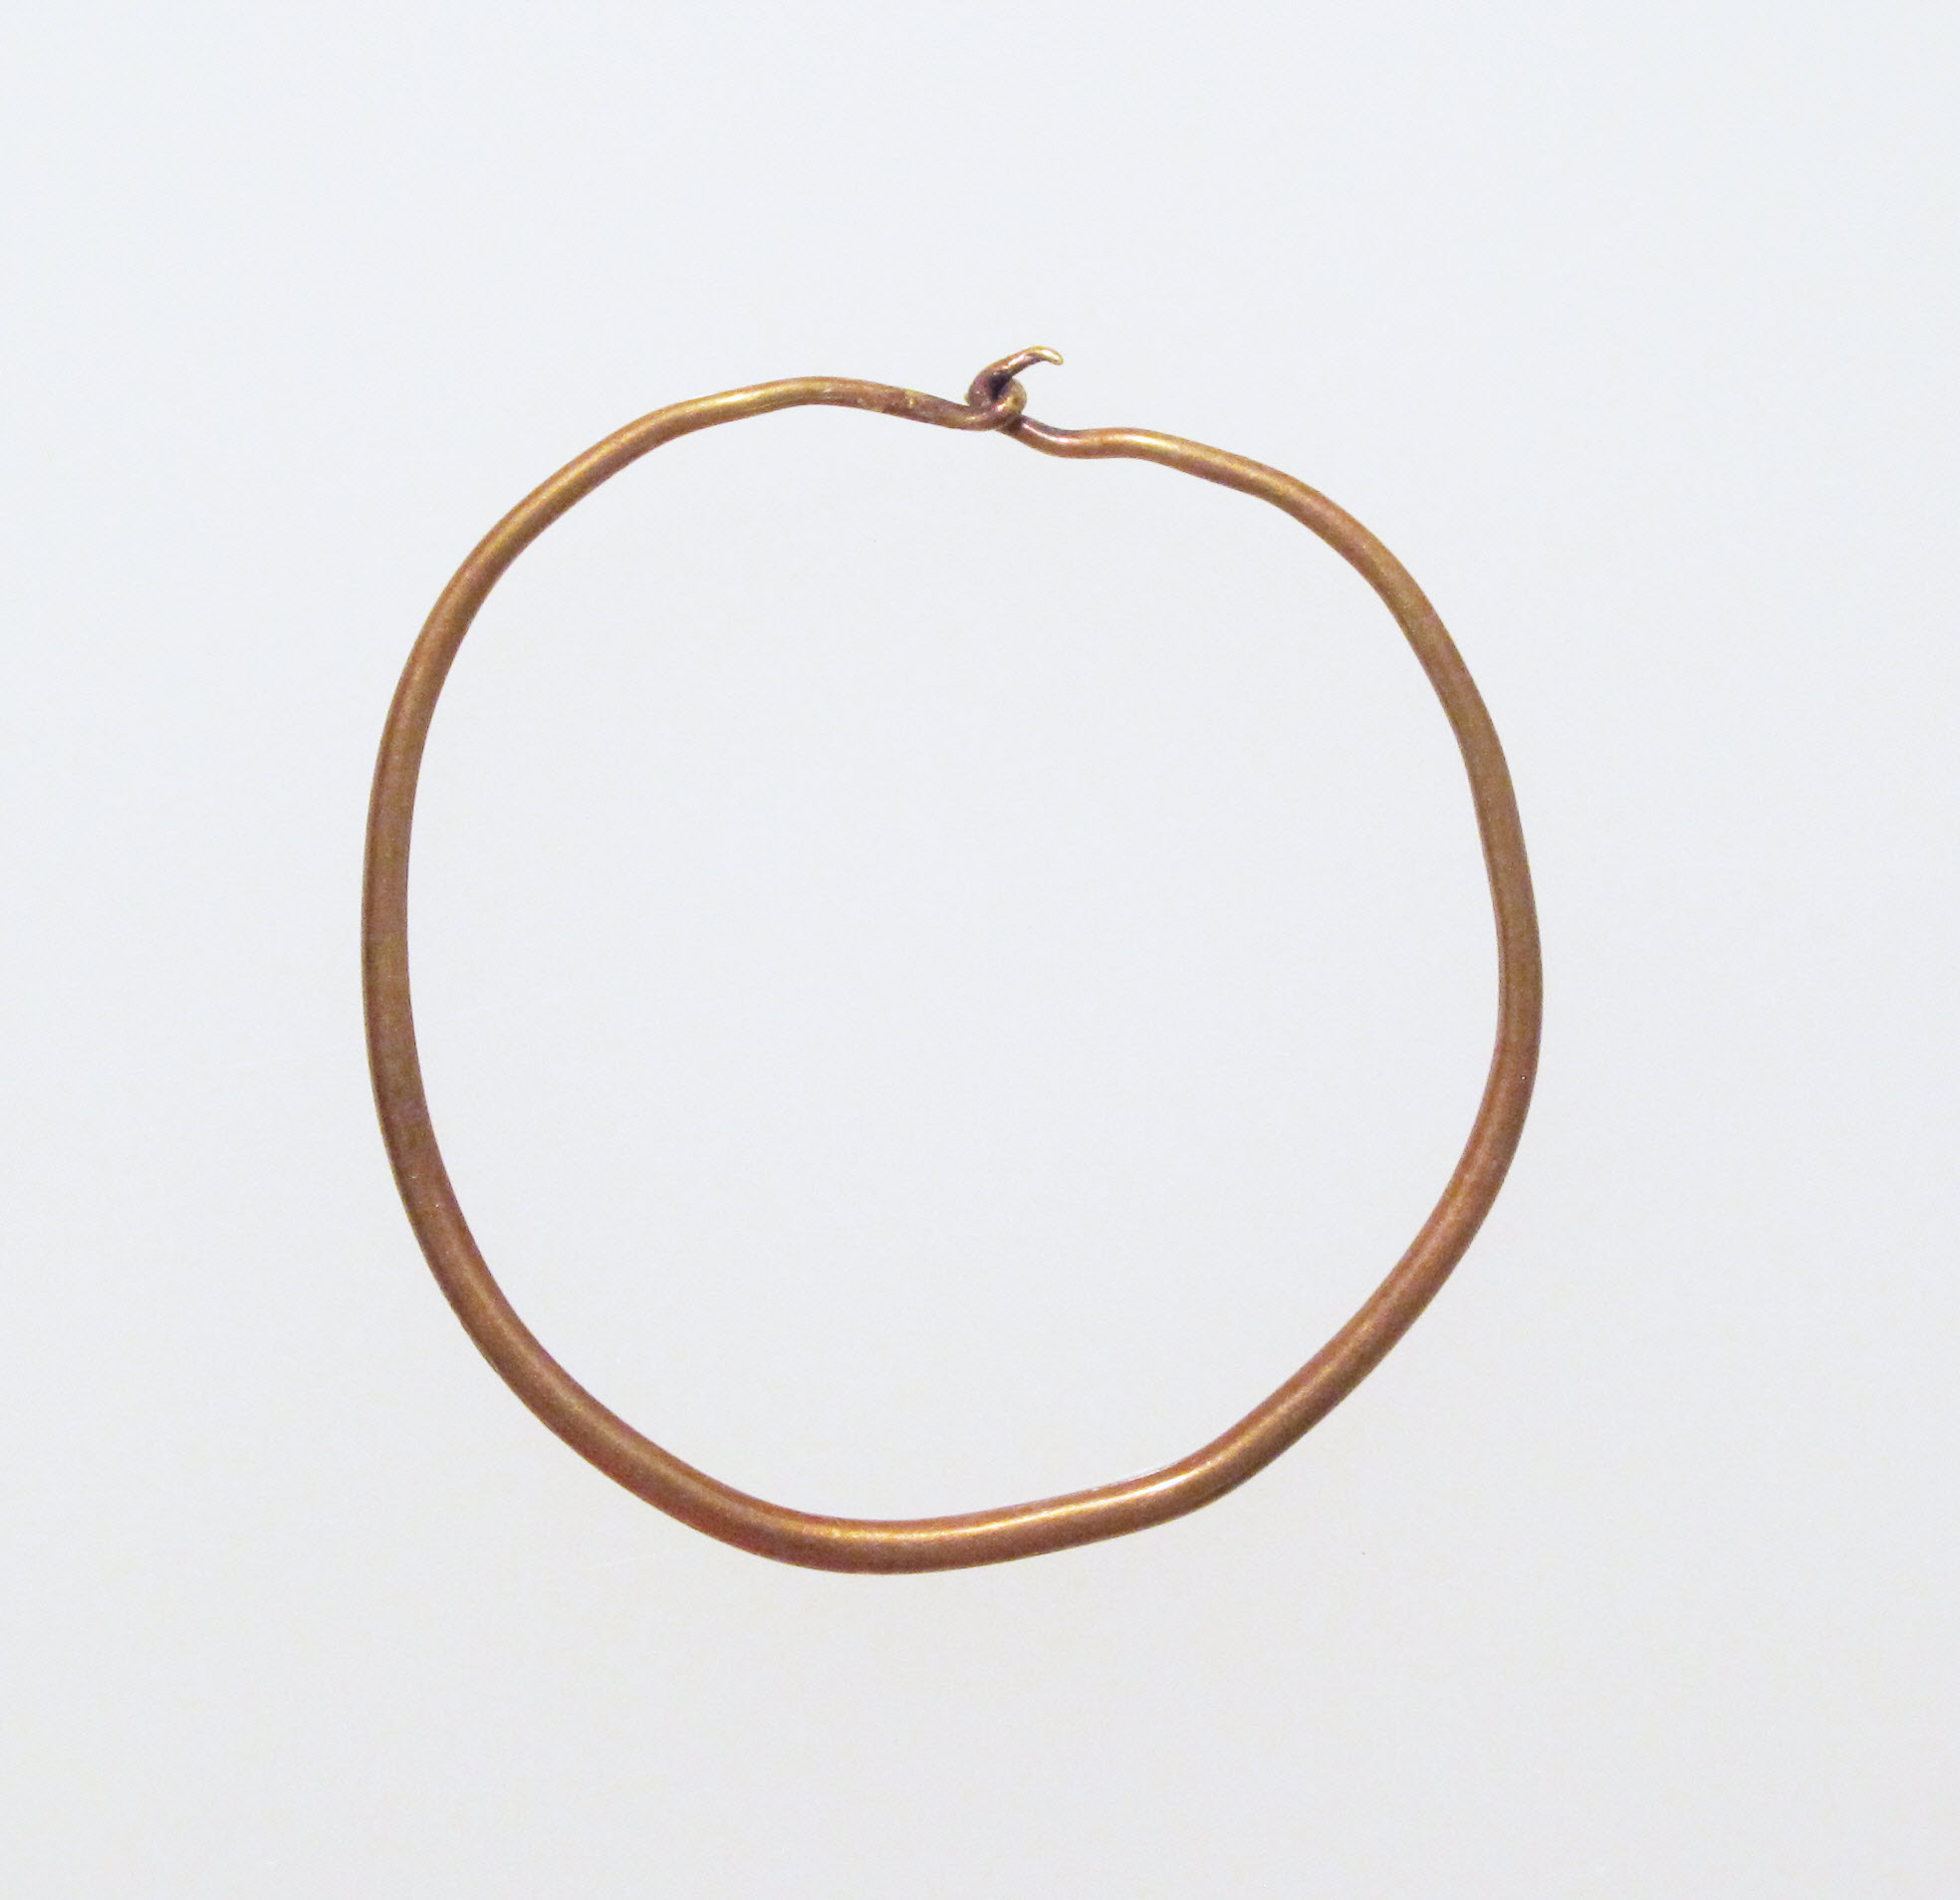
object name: earring loop type, plain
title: Earring-loop type, plain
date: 7000 BCE-330 CE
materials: gold